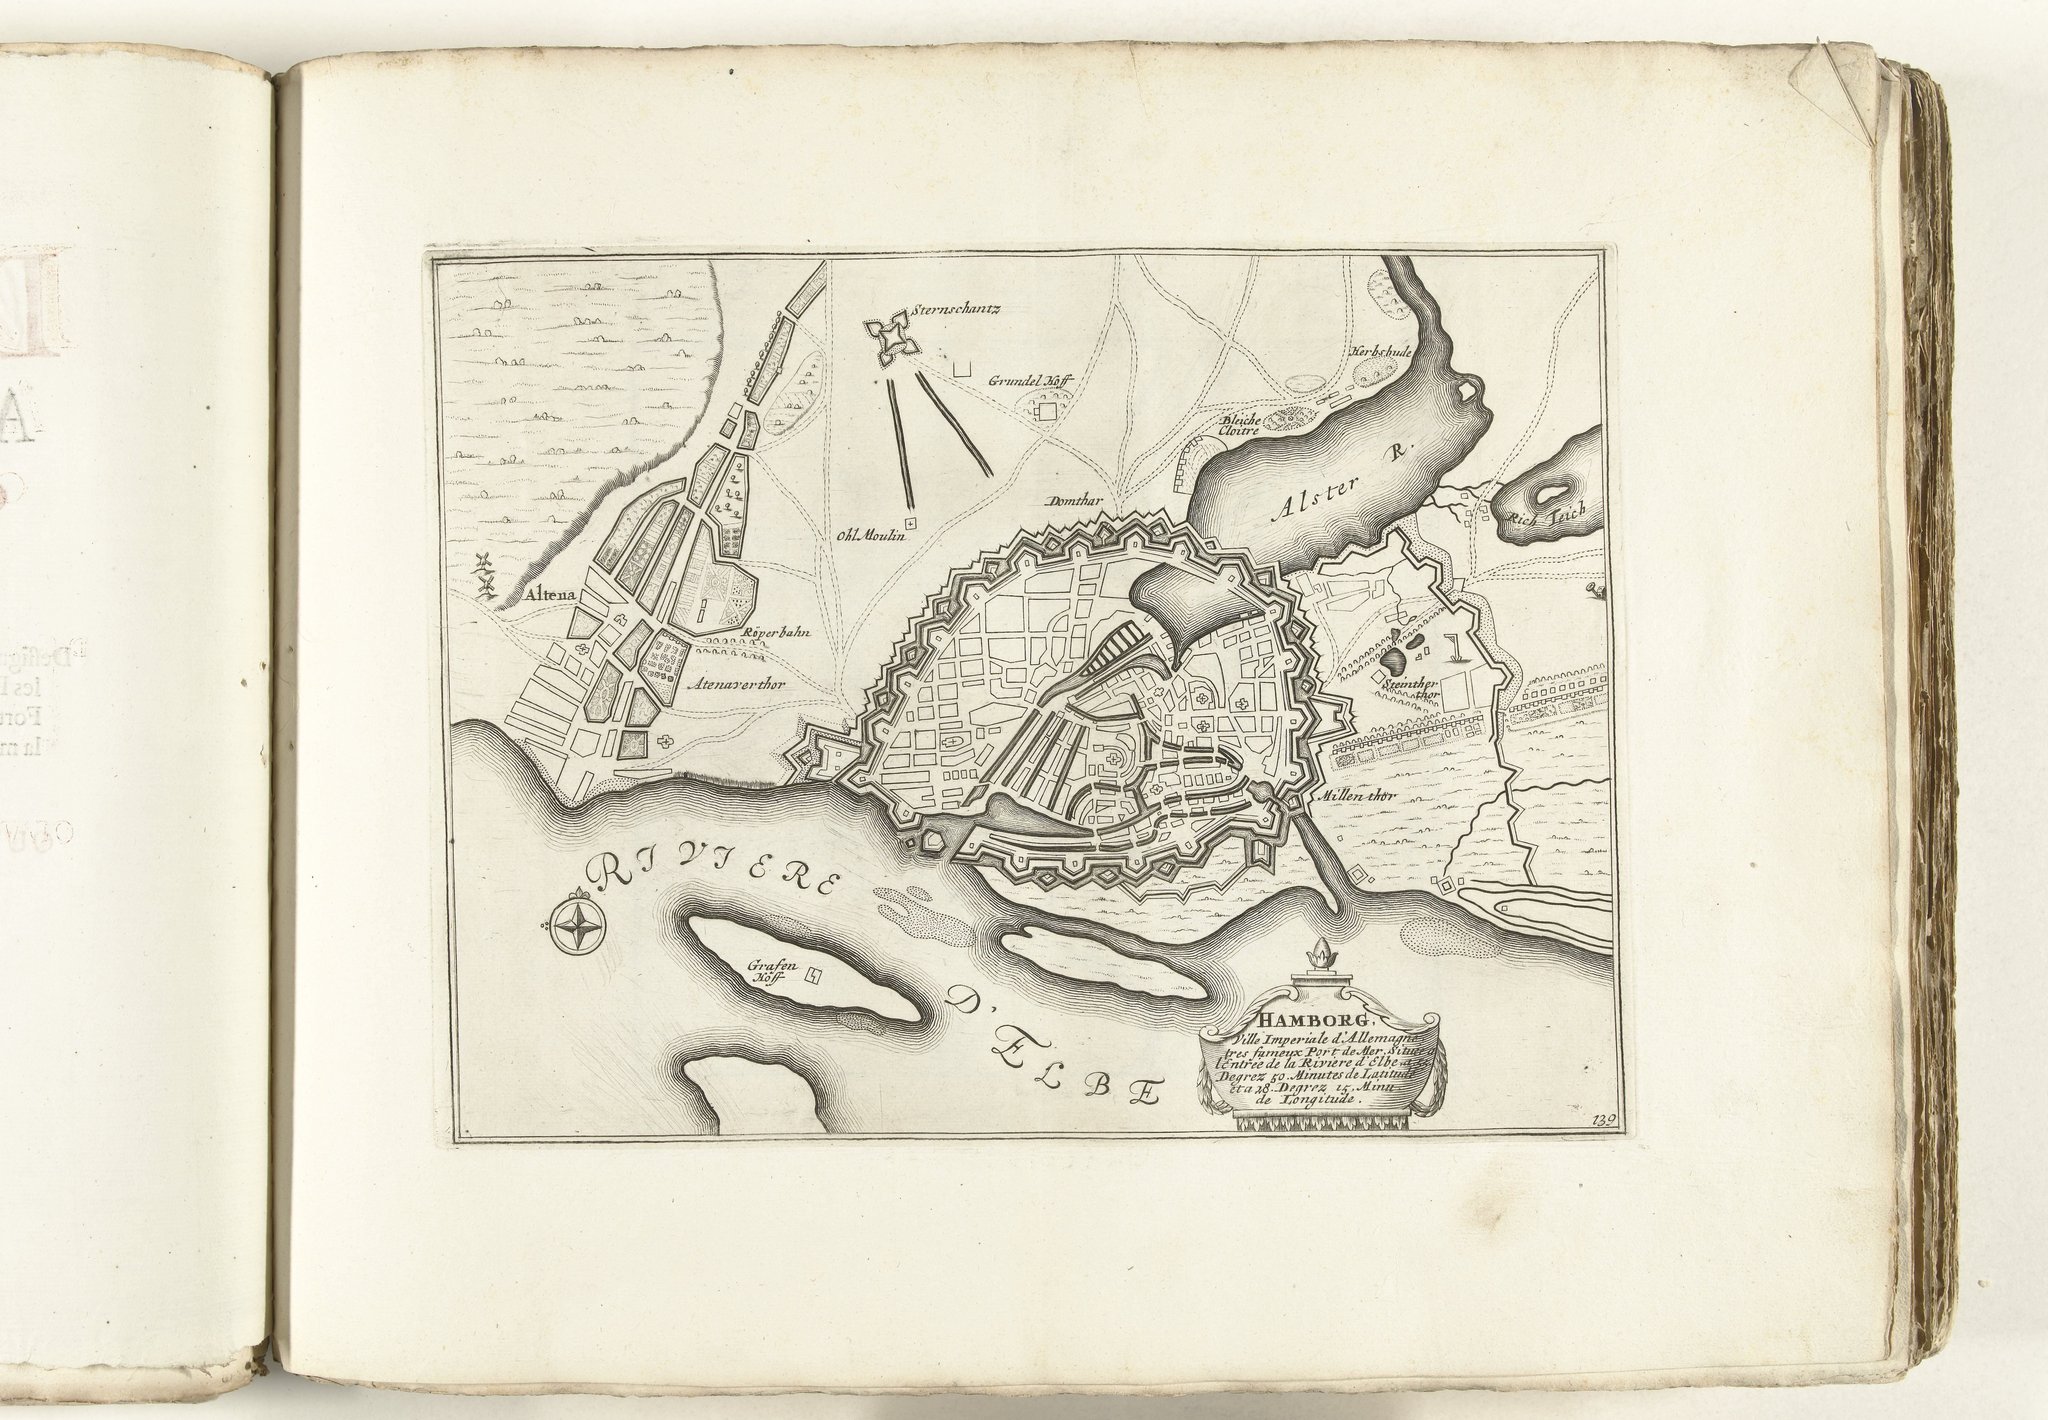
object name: map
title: Hamborg, Ville Imperiale d'Allemagne (...)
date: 1702-1703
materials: paper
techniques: engraving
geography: amsterdam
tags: fortress, maps of cities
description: Plattegrond van de versterkingen om de Duitse havenstad Hamburg. Plaat nr. 139 in het prentwerk bestaande in totaal uit 276 genummerde platen van vermaarde sterke steden en vestingen in het kader van de Spaanse Successieoorlog. Voor het merendeel zijn deze platen gekopieerd naar de anonieme Franse platen: in Les forces de l'Europe en in: Le theatre de la guerre, dans les Pays-Bas, beide oorspronkelijk uitgegeven door Nicolas de Fer te Parijs (1693-1697) in het kader van de Negenjarige Oorlog. Titel en opschriften in de plaat in het Frans.